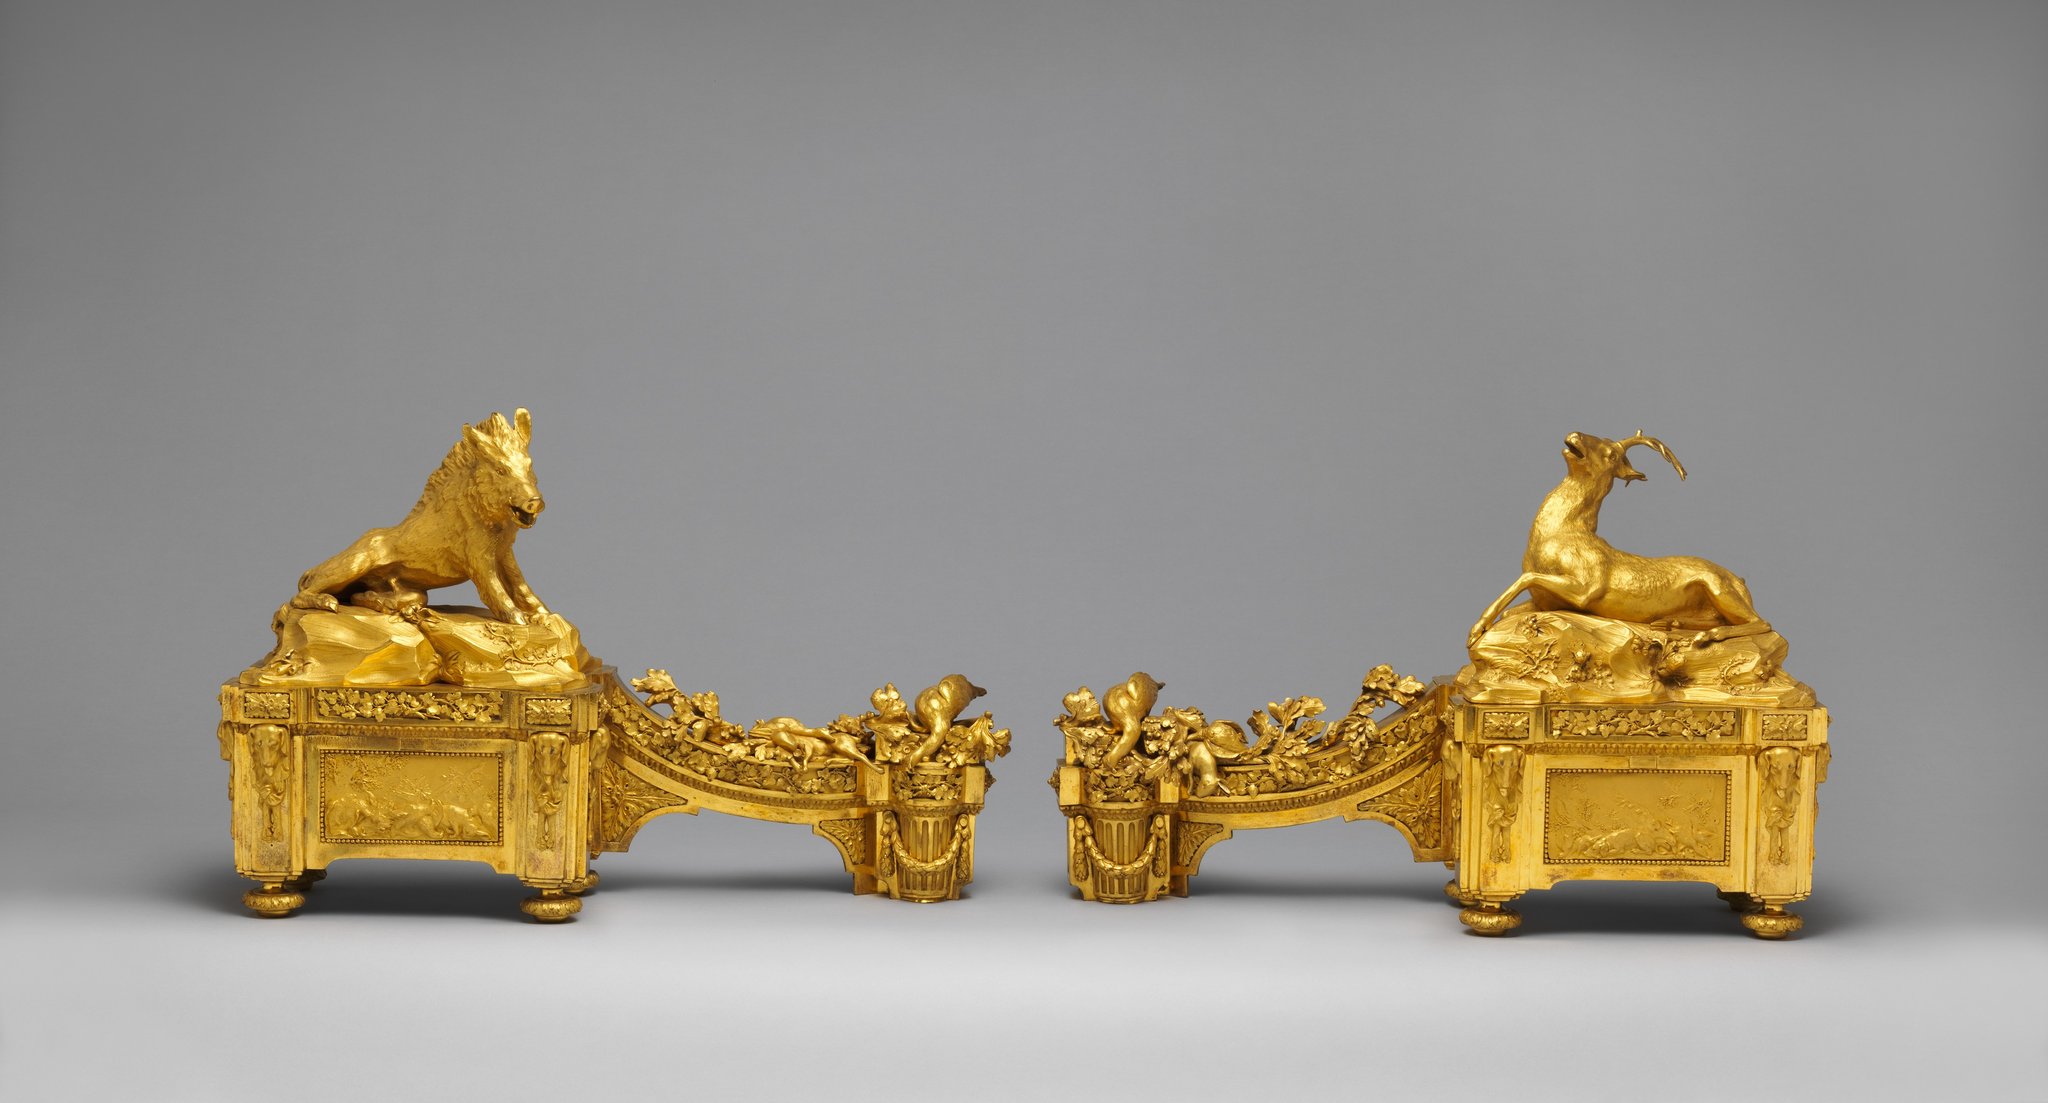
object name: firedog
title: Pair of firedogs (chenets)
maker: quentin-claude pitoin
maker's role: artist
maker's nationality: french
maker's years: 1720-1777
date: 1772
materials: gilt bronze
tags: boars,deer